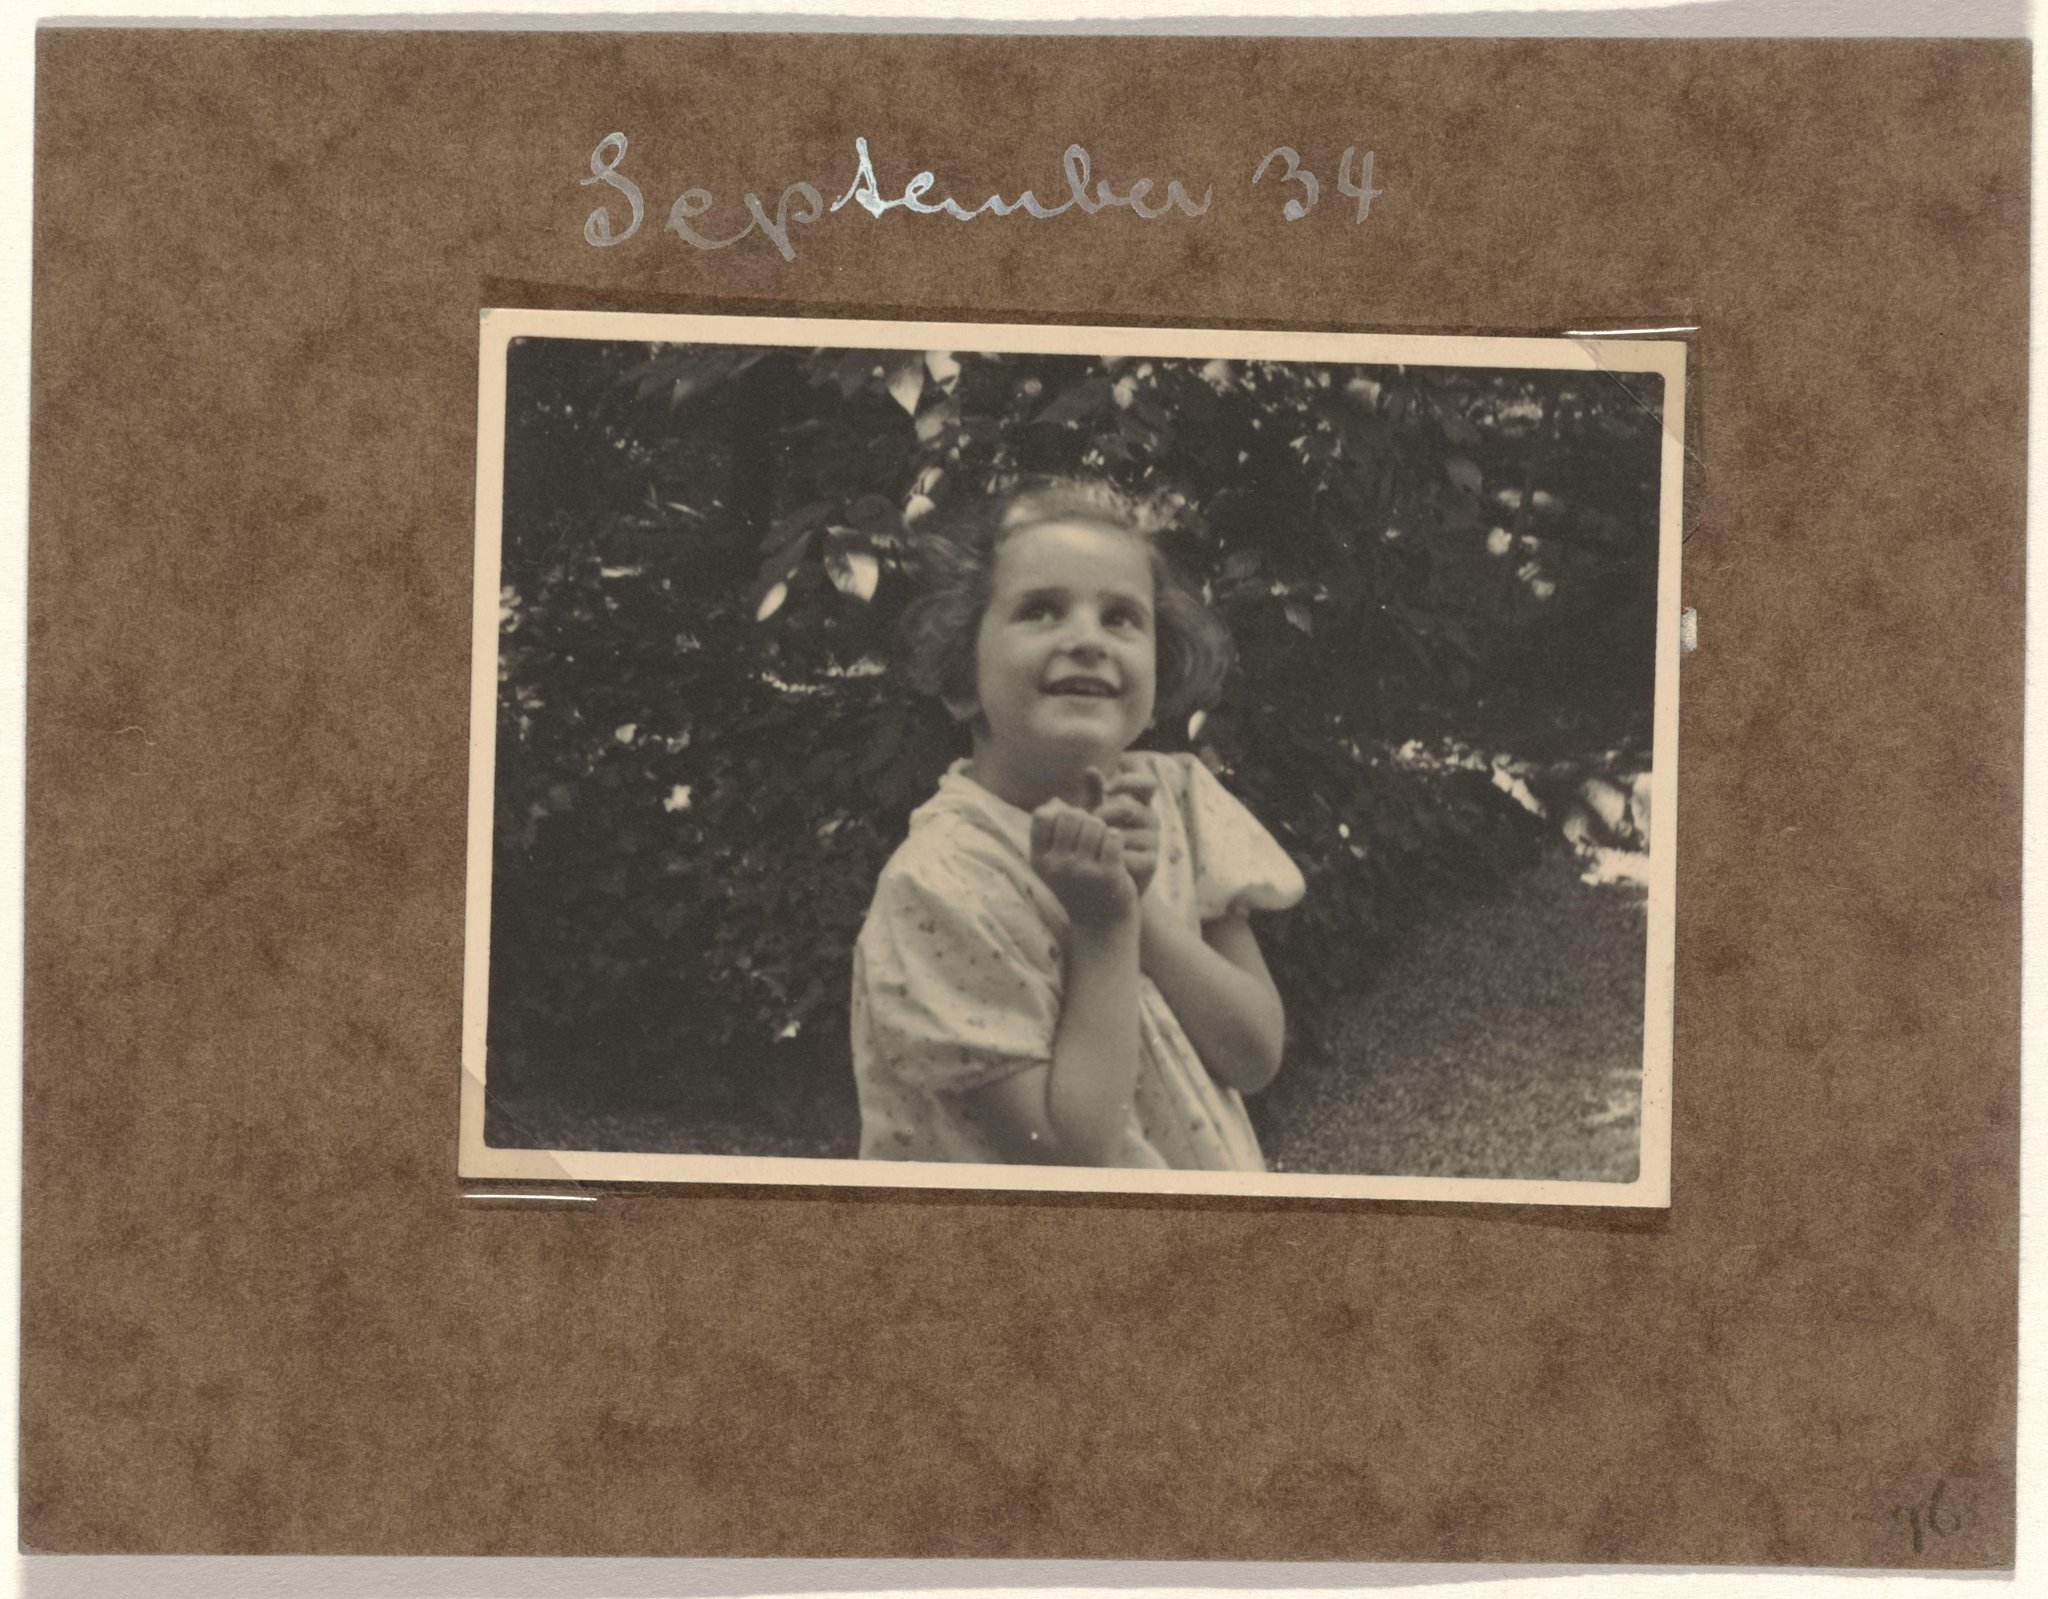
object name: photograph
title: Isabel Wachenheimer in een tuin tijdens een bezoek aan haar oom Willy Moos in Hamburg, september 1934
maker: Anonymous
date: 1909-1934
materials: photographic support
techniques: gelatin silver print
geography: hamburg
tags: leiden, isabel wachenheimer-elon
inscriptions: date: ‘September 34’